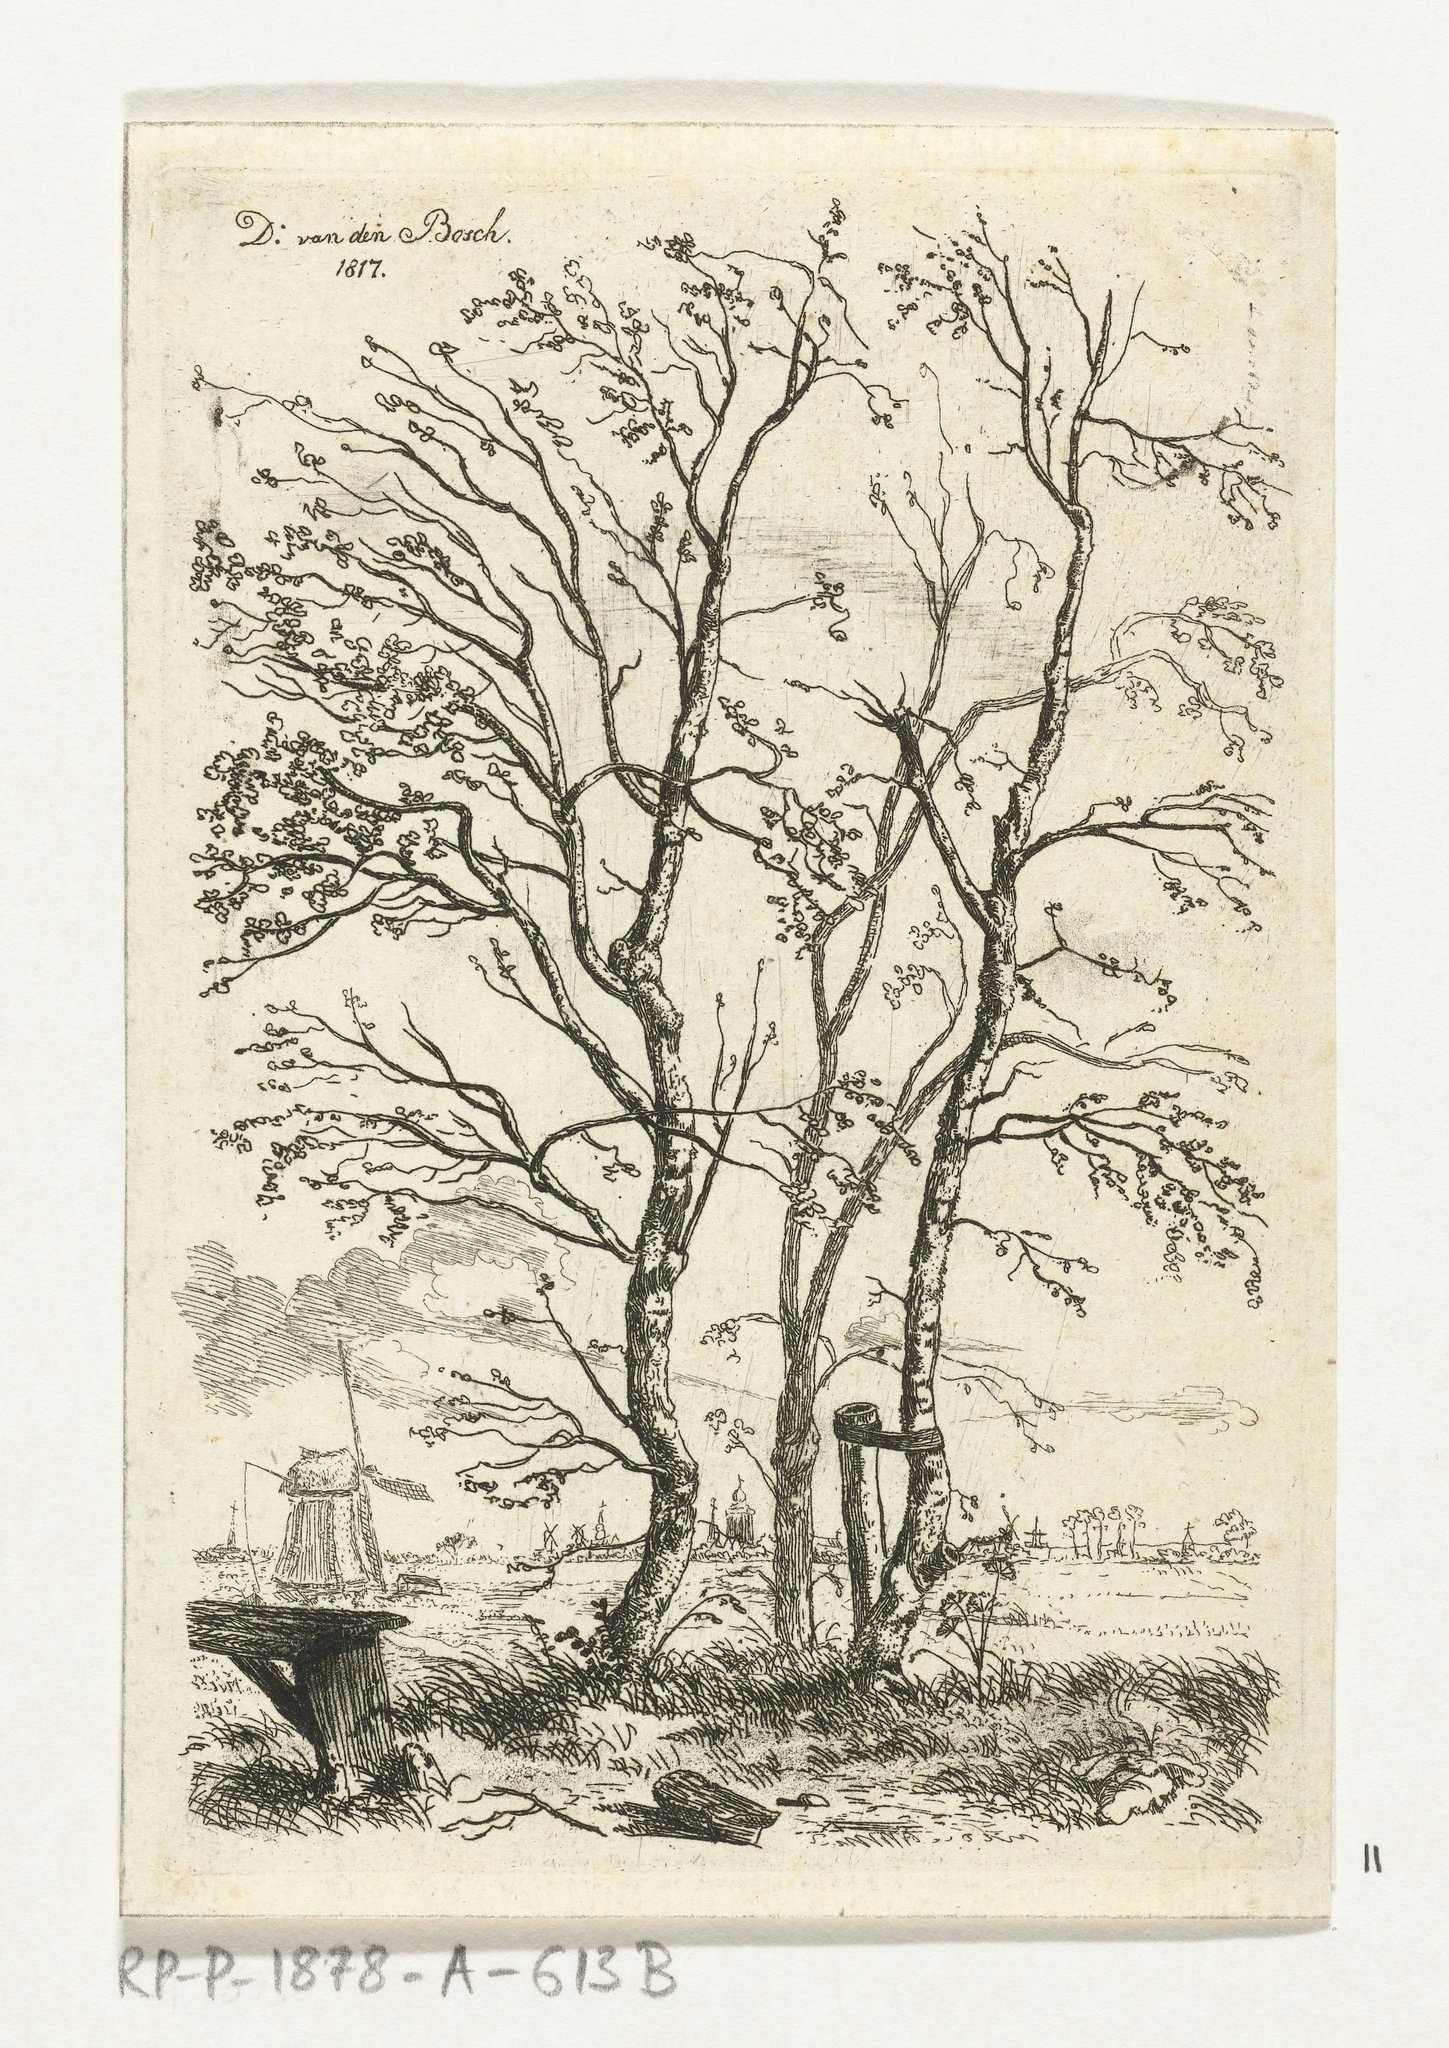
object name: print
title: Drie berkenbomen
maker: d. van den bosch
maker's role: print maker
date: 1817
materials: paper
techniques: etching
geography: netherlands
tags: trees: birch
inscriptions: collector's mark: Lugt 2227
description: Drie bijna bladerloze berkenbomen, waarvan een met een band aan een paal bevestigd is, op de voorgrond links een bank. In de verte een gezicht op een stad, links een molen.